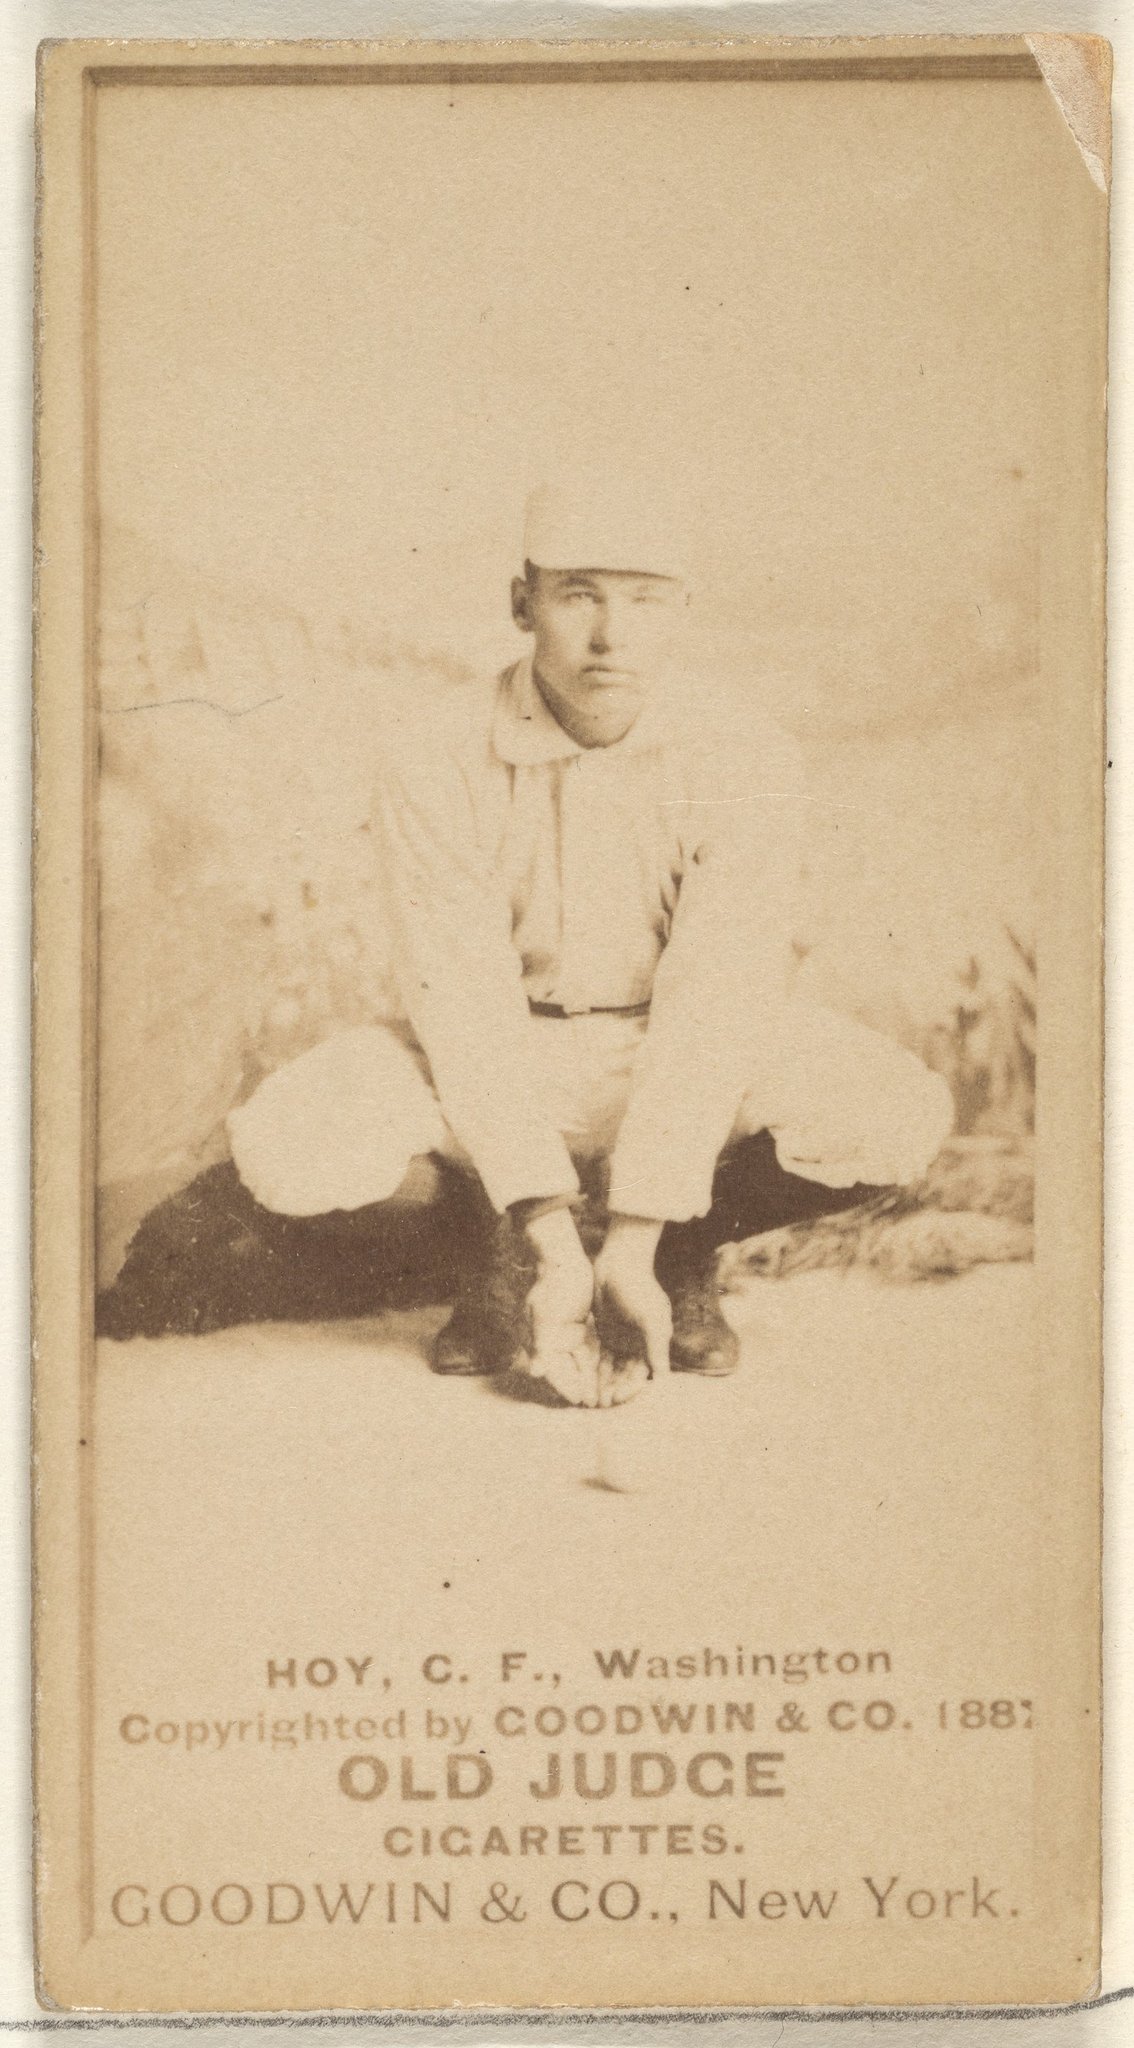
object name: baseball card, photograph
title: William Ellsworth "Dummy" Hoy, Center Field, Washington Nationals, from the Old Judge series (N172) for Old Judge Cigarettes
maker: goodwin & company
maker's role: publisher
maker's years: 1850-1950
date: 1887-1890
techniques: albumen silver print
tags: men,portraits,baseball,athletes